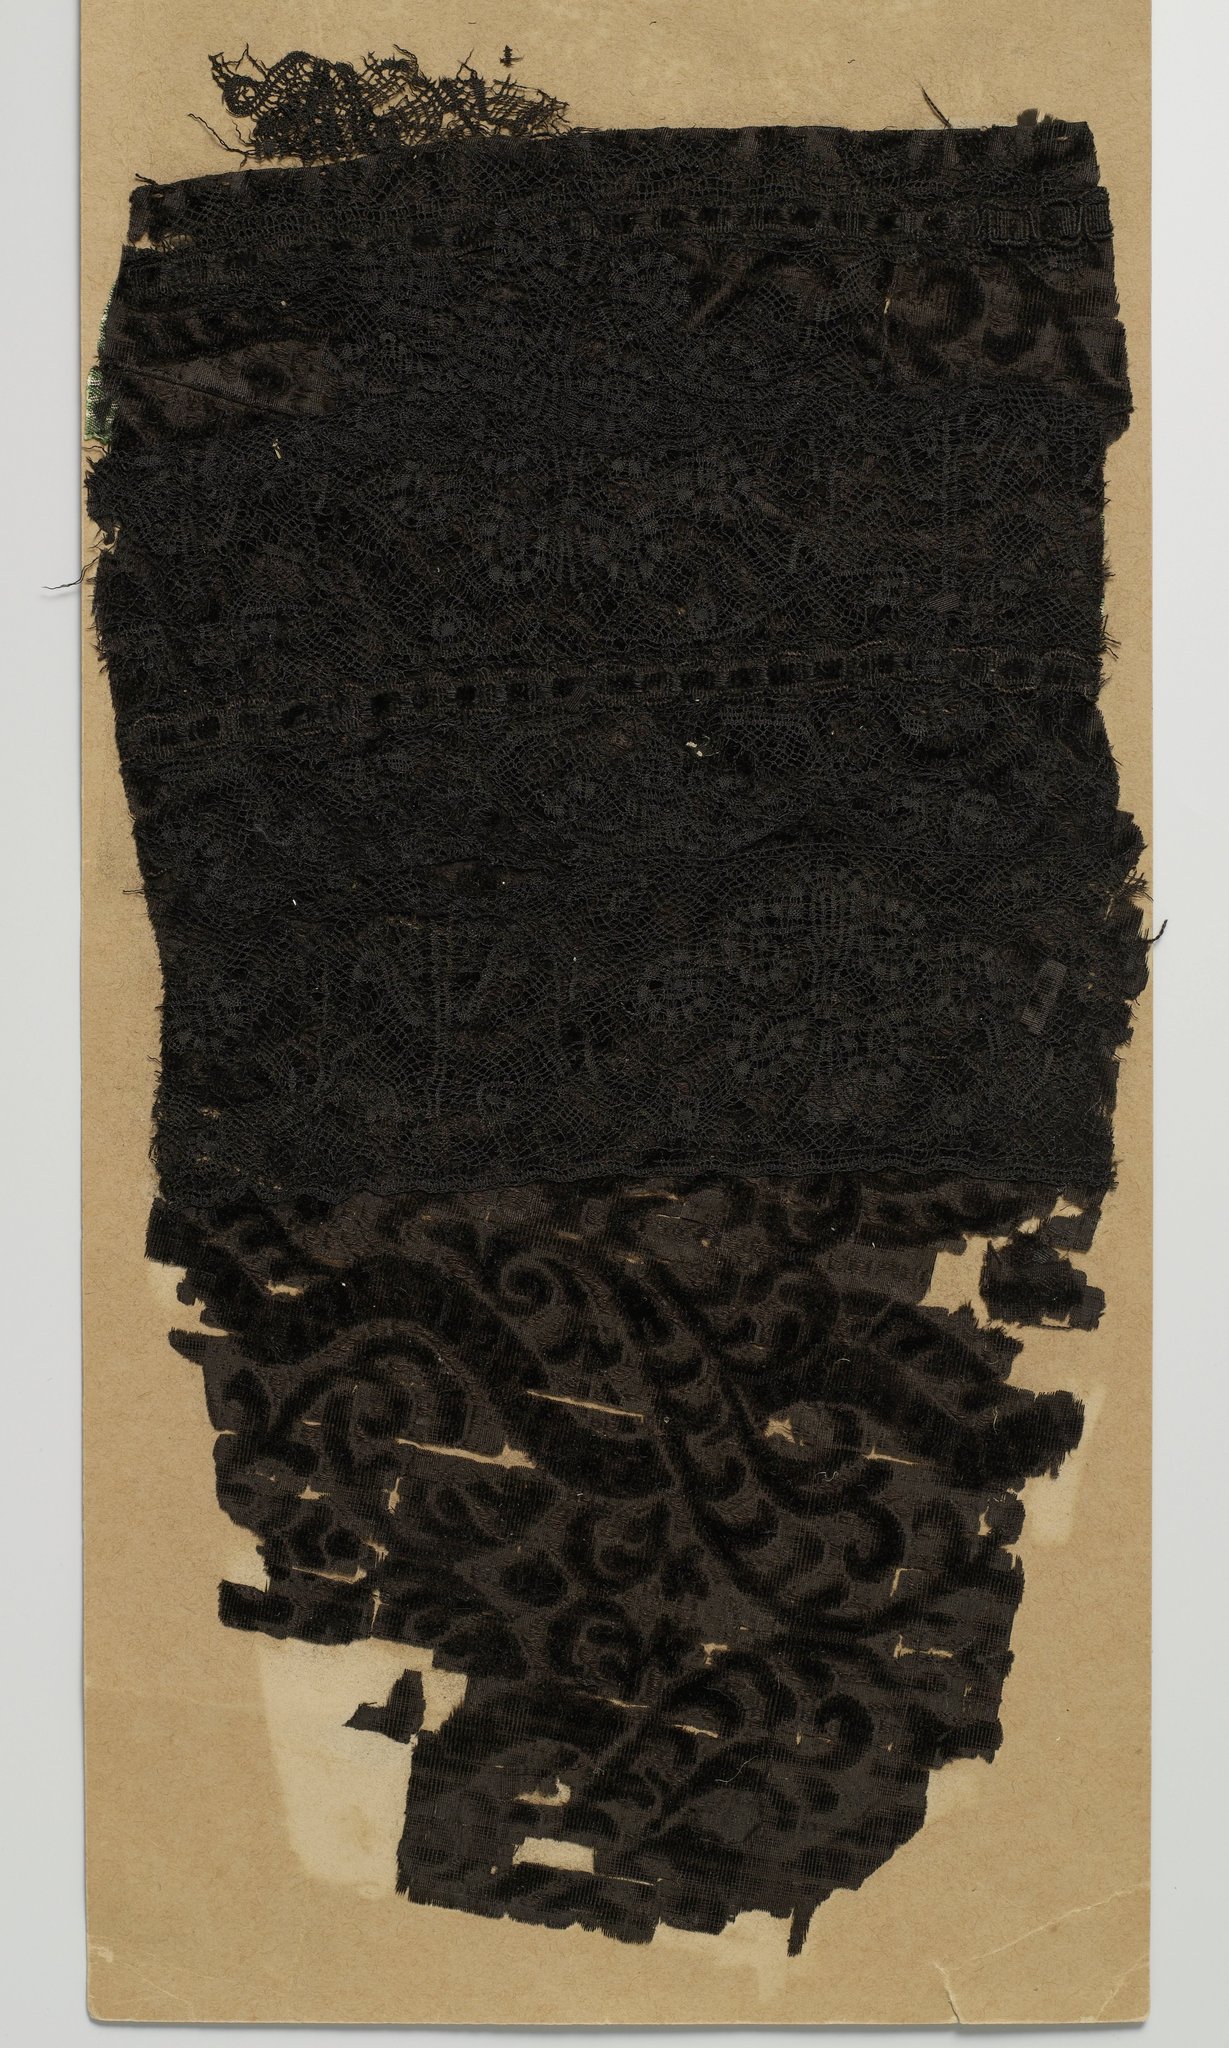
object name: mantle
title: Fragment van een mantel van ciseléfluweel met kloskant, volgens overlevering afkomstig van Hugo de Groot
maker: Anonymous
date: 1600-1699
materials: silk, velvet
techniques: lace, weave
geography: netherlands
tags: delft, hugo de groot, rotterdam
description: Fragment van een mantel van zwarte ciseléfluweel waarop zwarte kloskant is genaaid. Het fragment is volgens overlevering afkomstig van een mantel van Hugo de Groot.